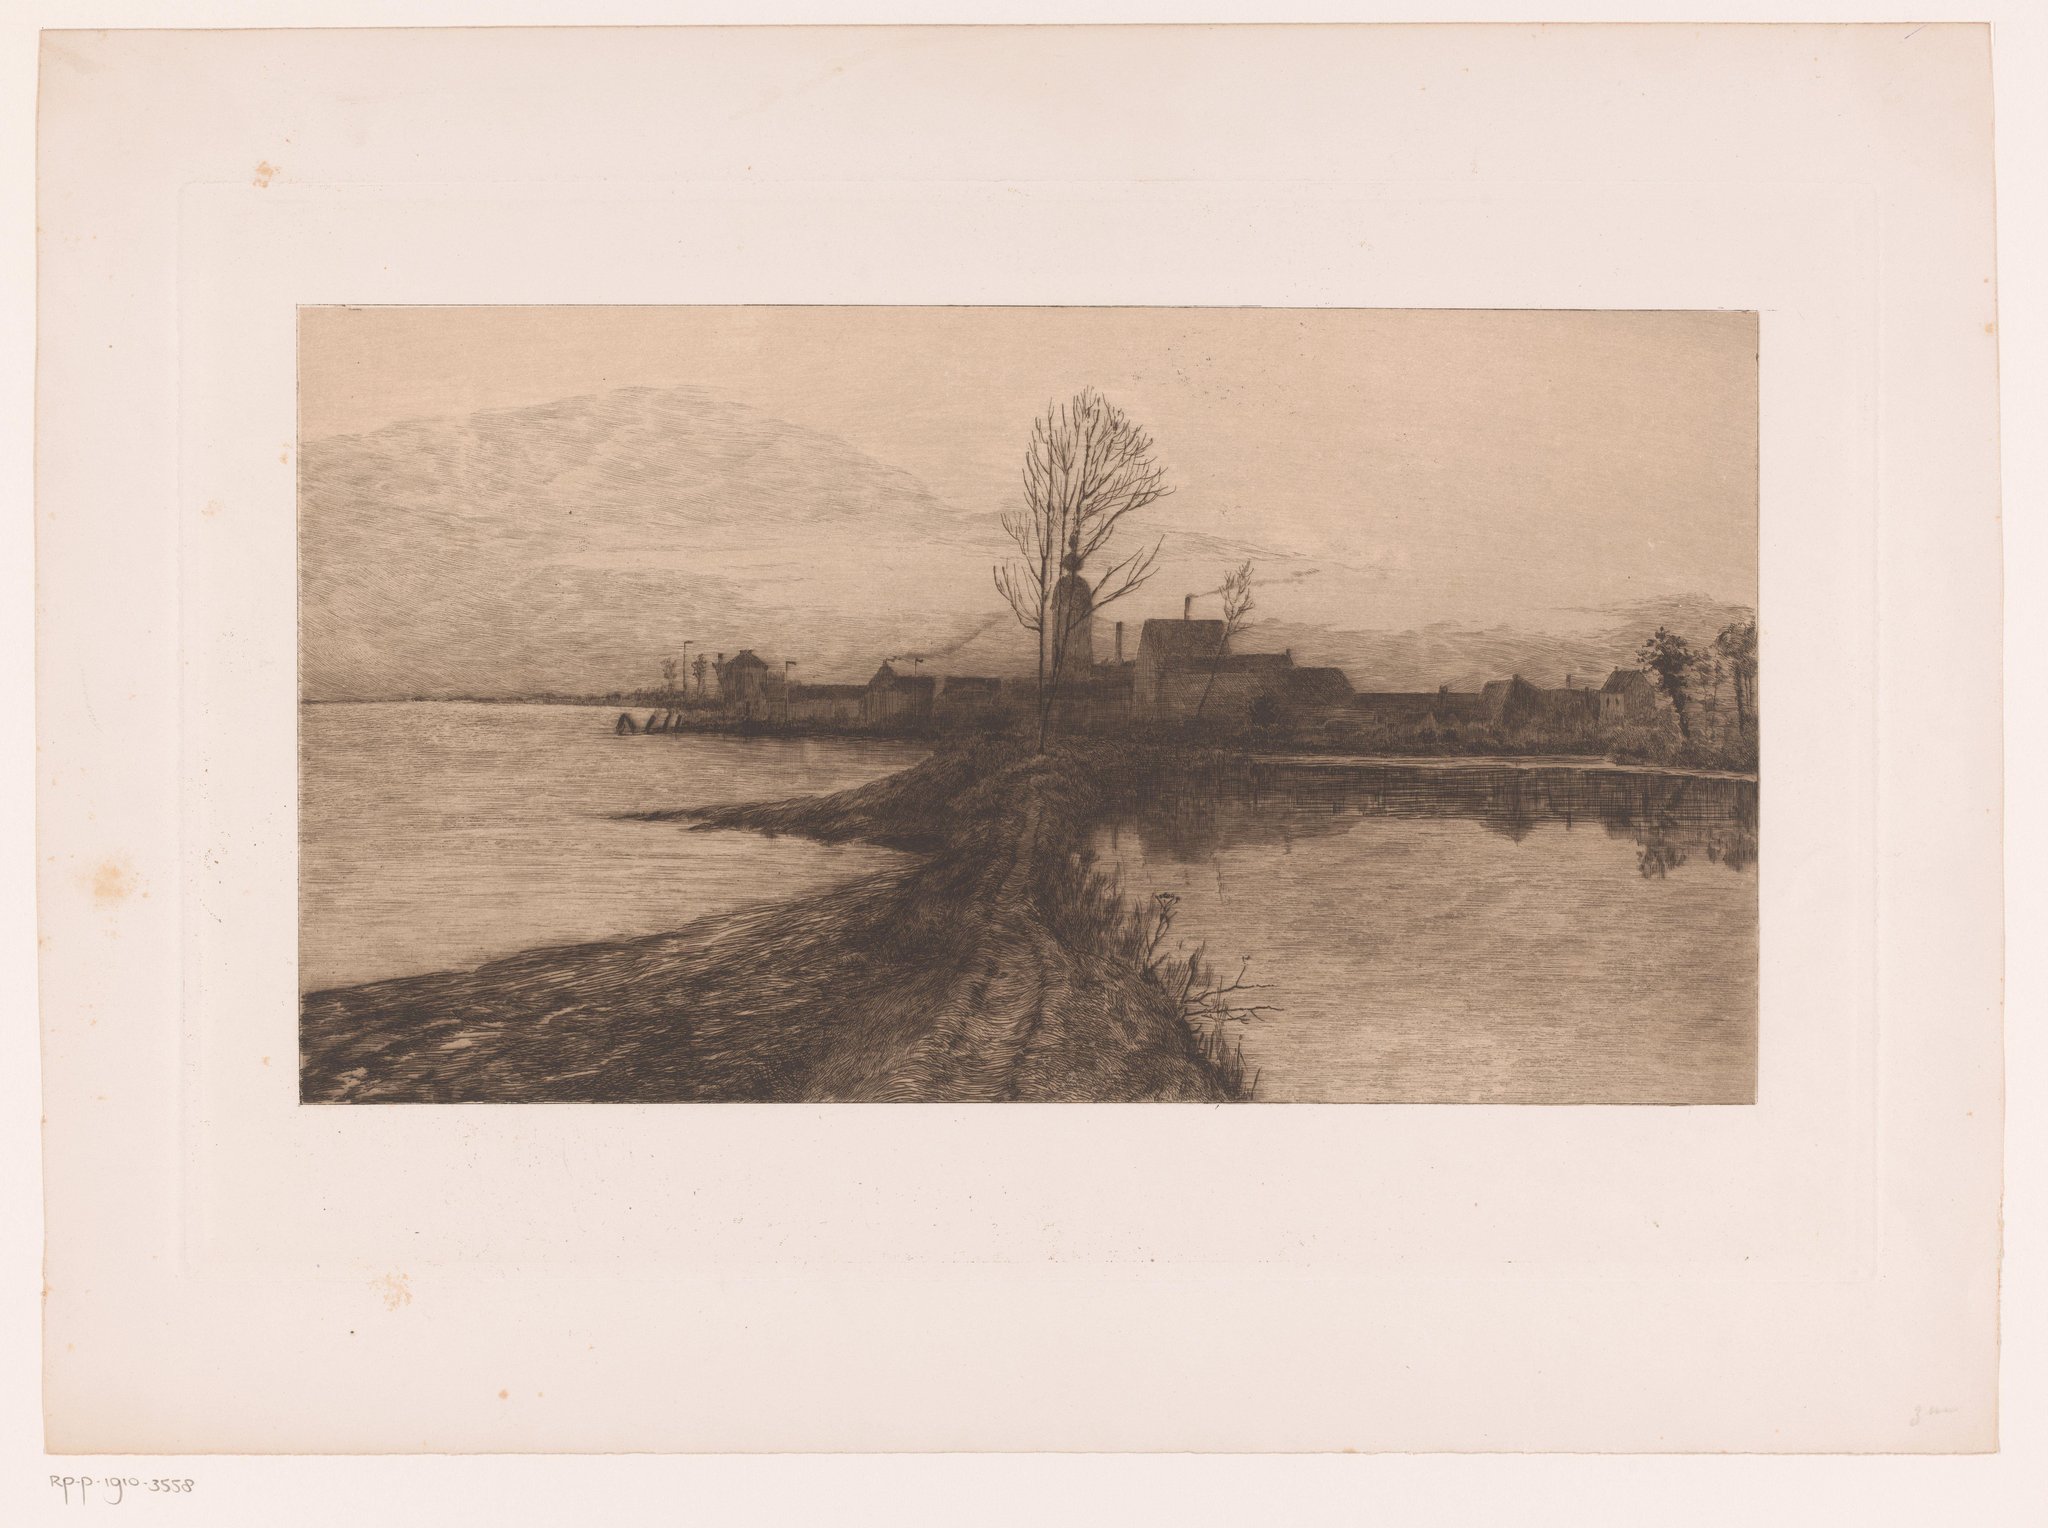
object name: print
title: Gezicht op bebouwing aan het eind van een smal verhoogd pad tussen twee meren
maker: jules guiette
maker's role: print maker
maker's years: 1852-1901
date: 1862-1901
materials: paper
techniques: etching, intaglio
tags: prospect of village, silhouette of village, lake, parts of church exterior and annexes: tower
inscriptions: collector's mark: Lugt 2228, annotation: ‘3me’